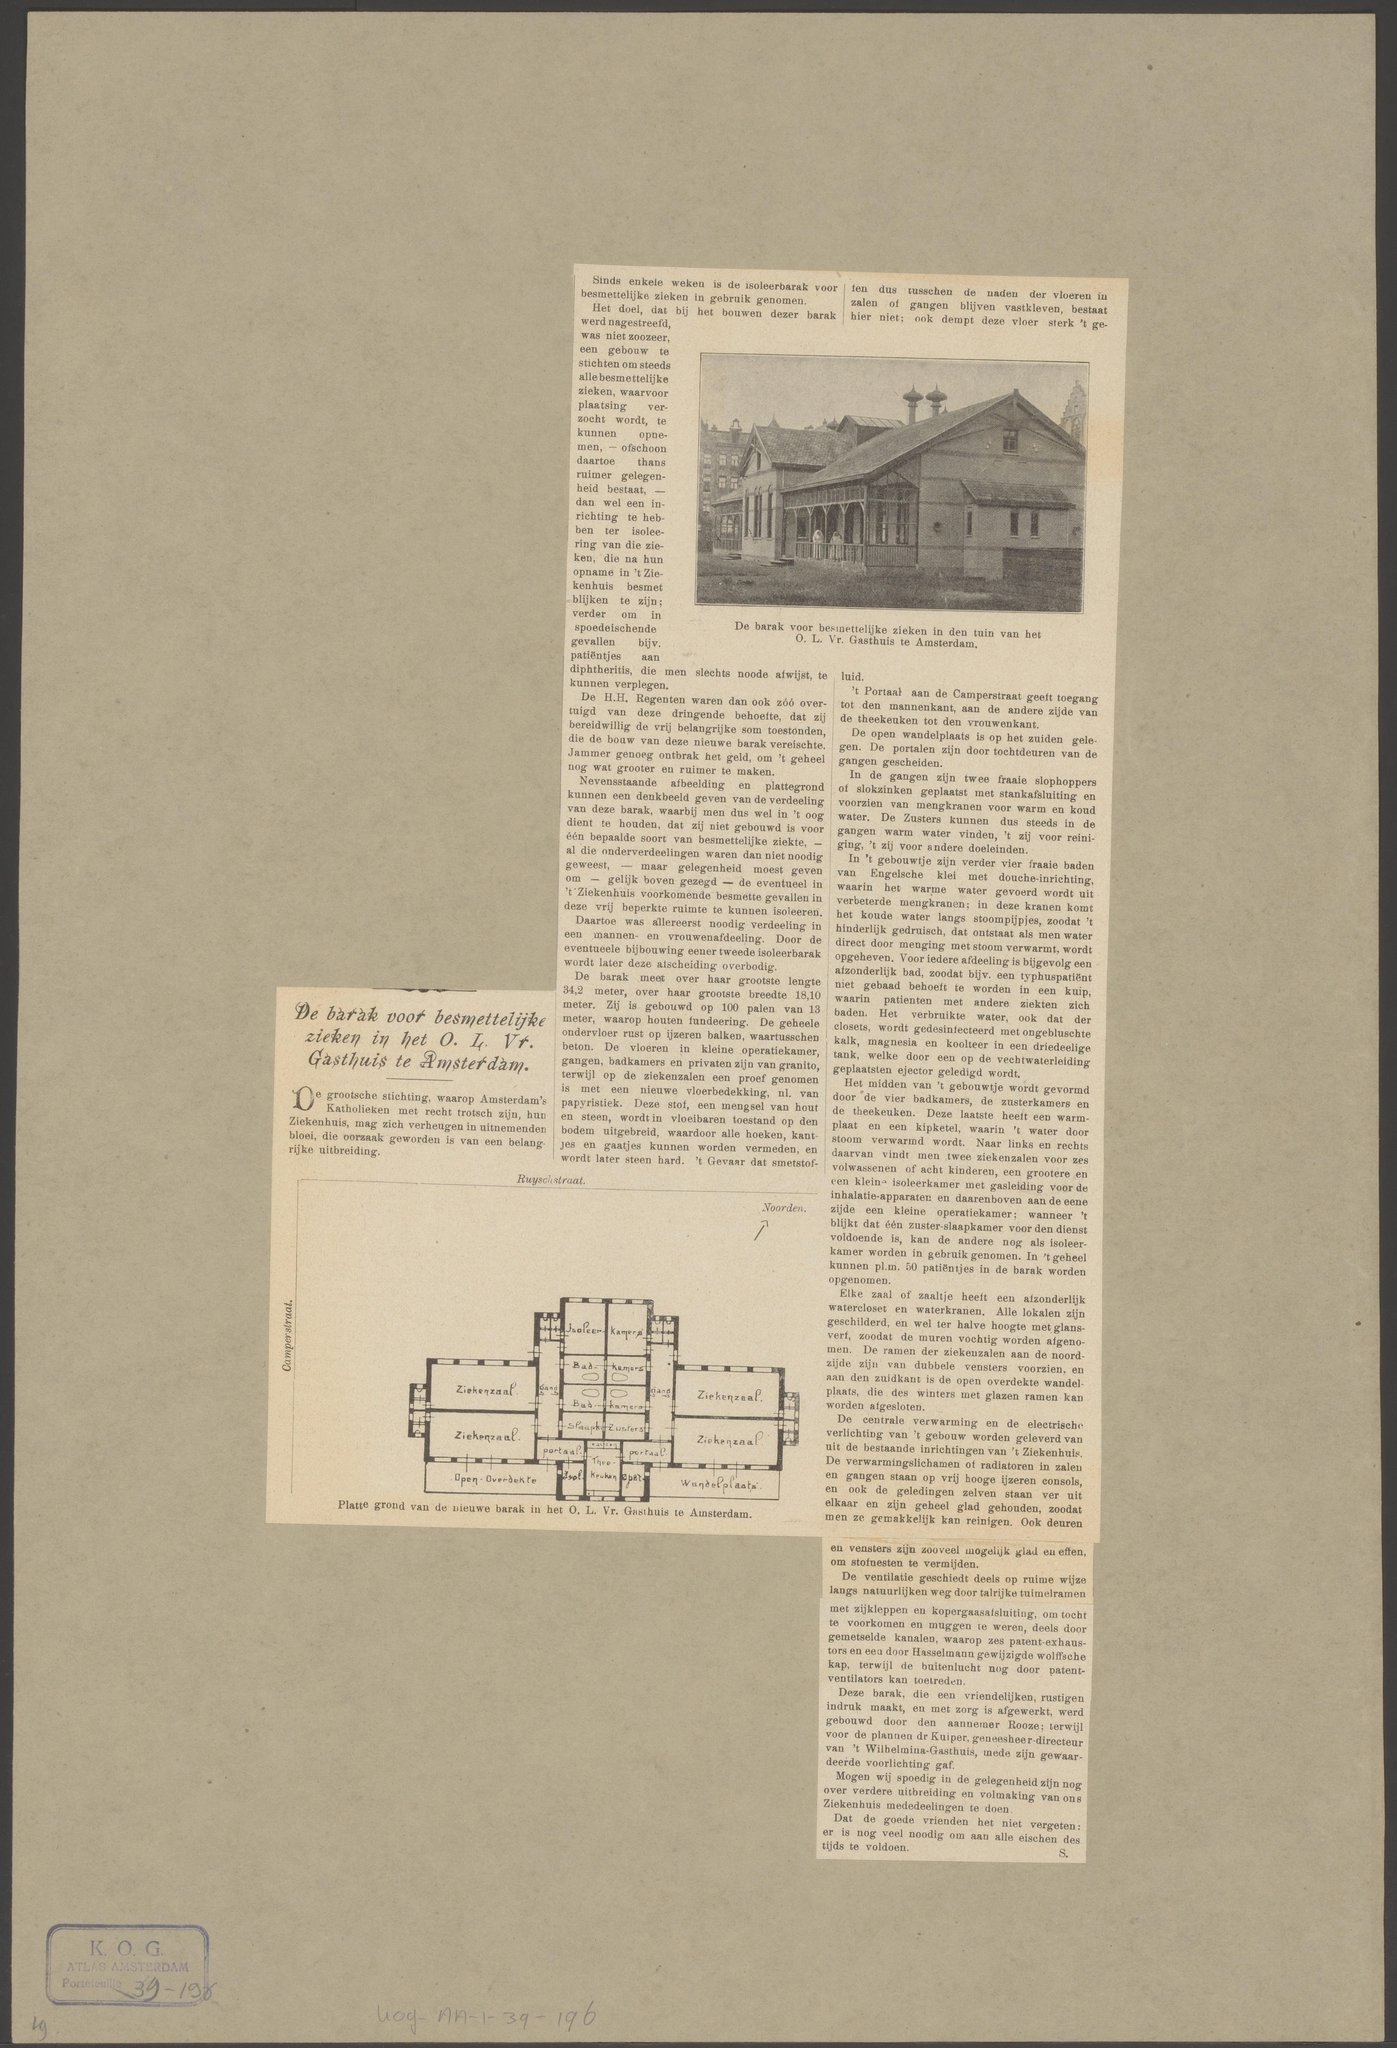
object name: photomechanical print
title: De barak voor besmettelijke zieken in het O.L.Vr. Gasthuis te Amterdam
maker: Anonymous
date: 1902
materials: paper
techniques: letterpress printing, line block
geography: amsterdam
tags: floor plan ~ architectural design or model, quarantine, hospital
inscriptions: collector's mark: Lugt 1641b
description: Object bestaat uit drie aan elkaar geplakte bladen. Onderwerpsrubriek binnen de Atlas Amsterdam: Armwezen en liefdadige instellingen: V. Ziekenhuizen: O.L. Vrouwe Gasthuis.